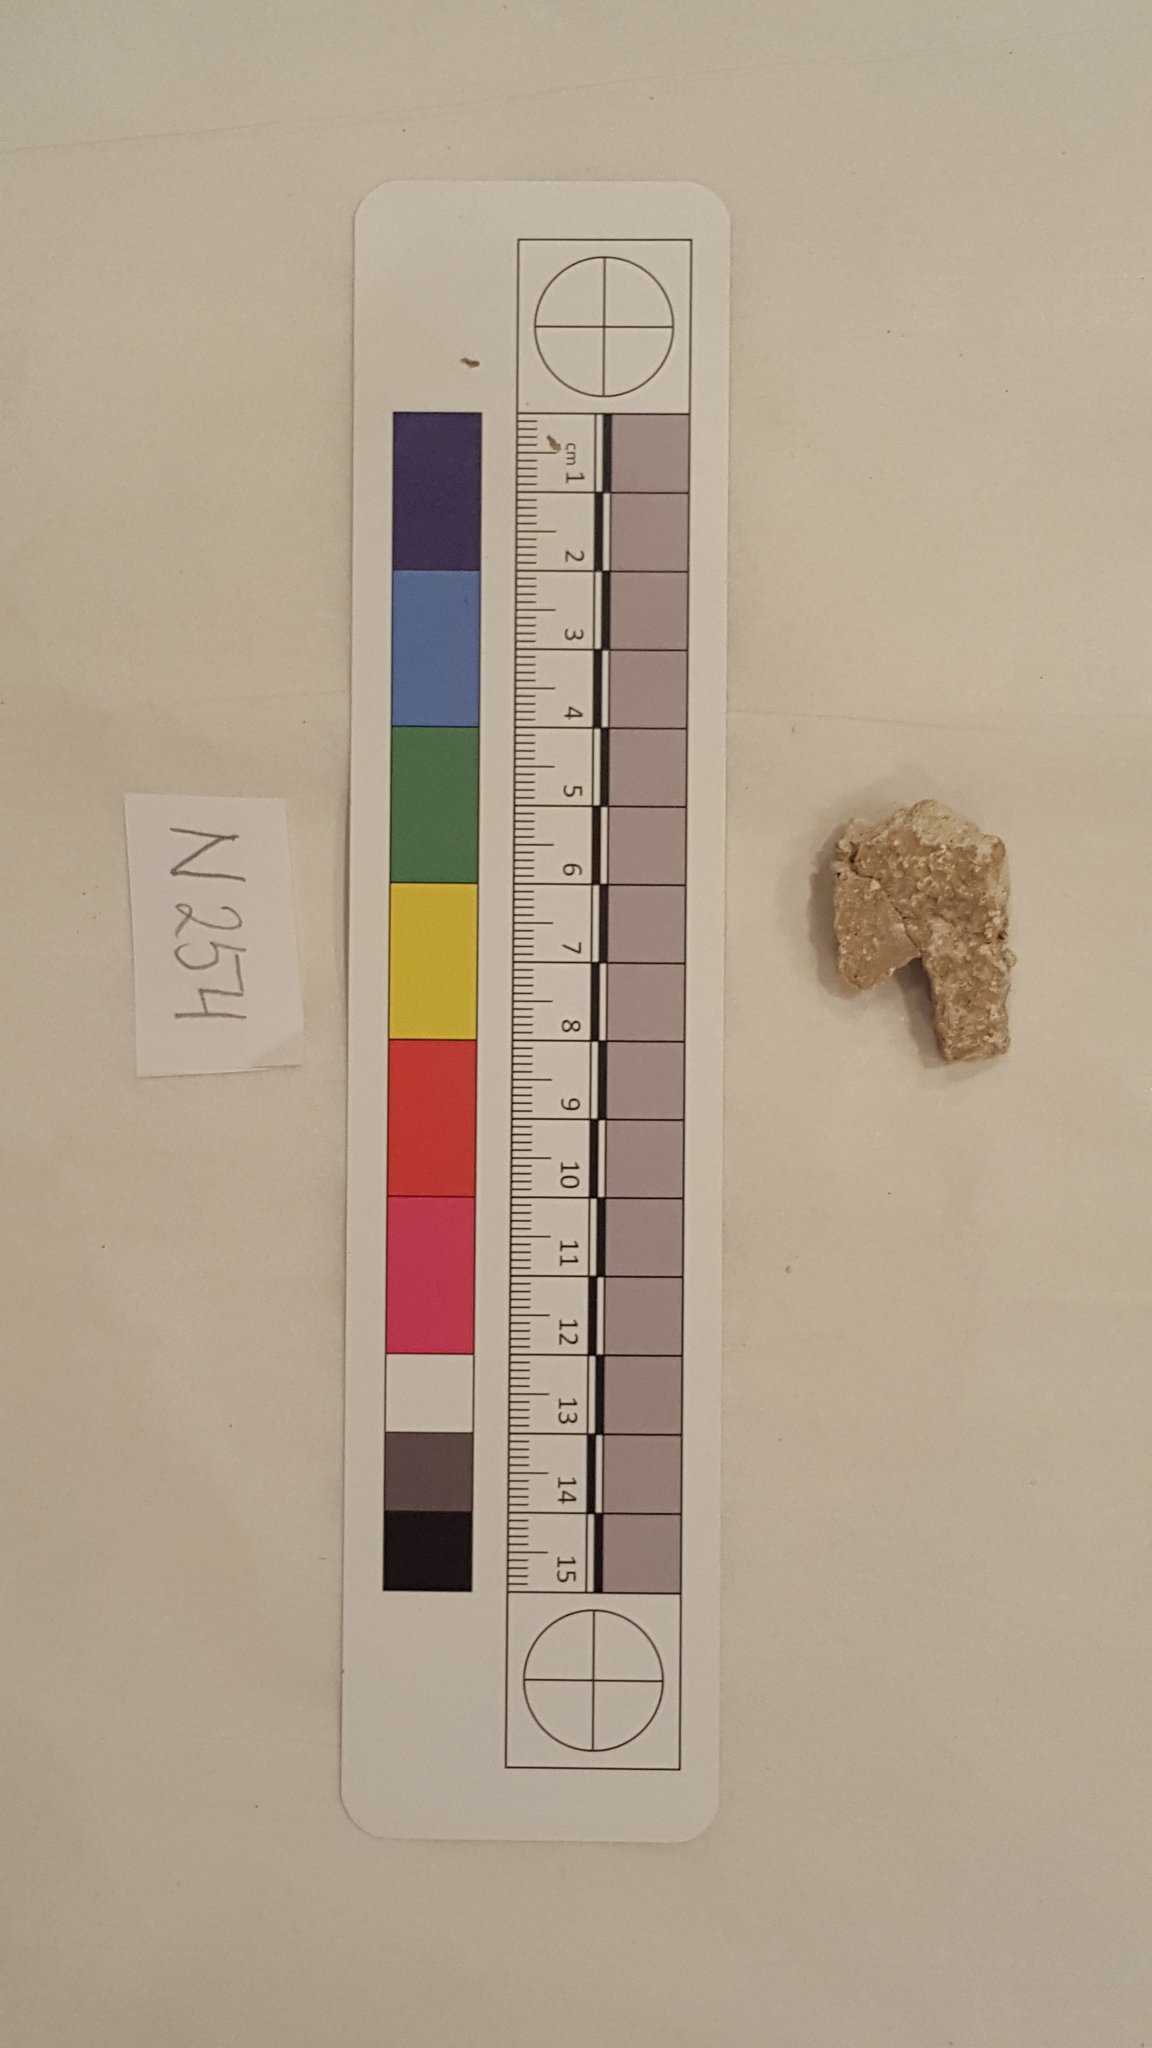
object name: fragment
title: Stucco Fragment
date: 701-1200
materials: plaster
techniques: carving, painting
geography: iran